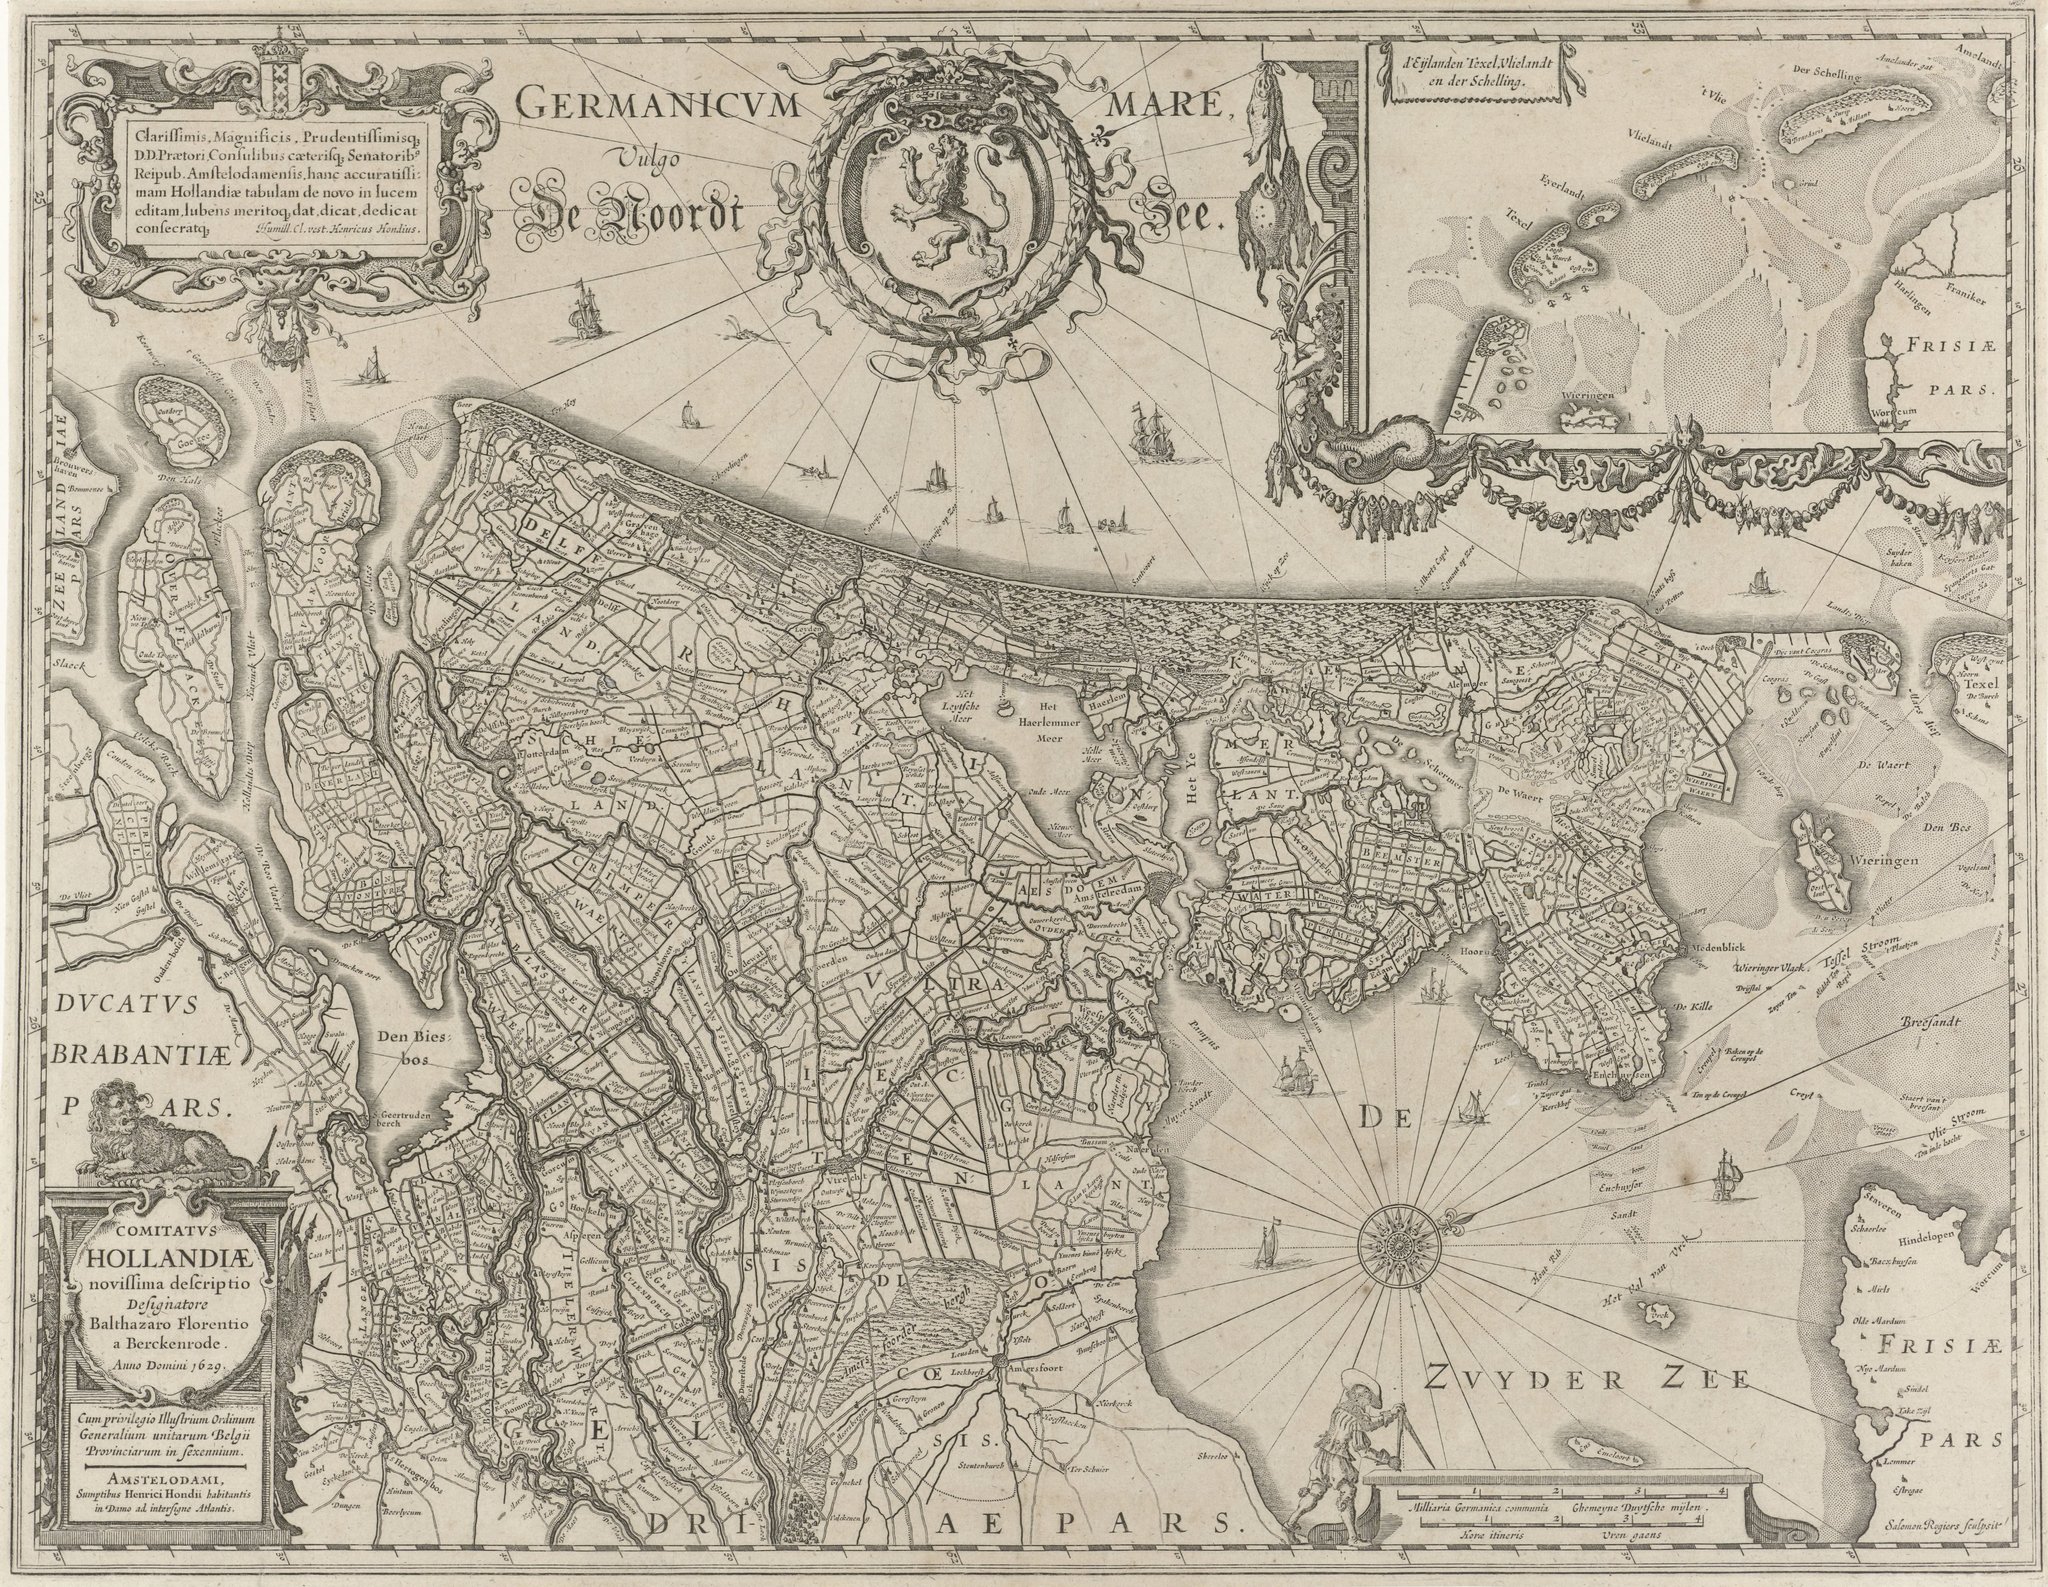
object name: print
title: Comitatus Hollandiae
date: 1629-1635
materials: paper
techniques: engraving, etching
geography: amsterdam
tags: maps of separate countries or regions, holland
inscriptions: collector's mark: Lugt 2228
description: Topografische kaart van de provincie Holland met bovenaan de Noordzee en het wapen van Holland. Linksboven een cartouche met het wapen van Amsterdam en een dedicatie (aan de regenten van Amsterdam). Linksonder een cartouche met de titel, en rechtsboven een met vissen versierde cartouche met daarin de Waddeneilanden. Rechtsonder de schaalverdeling.